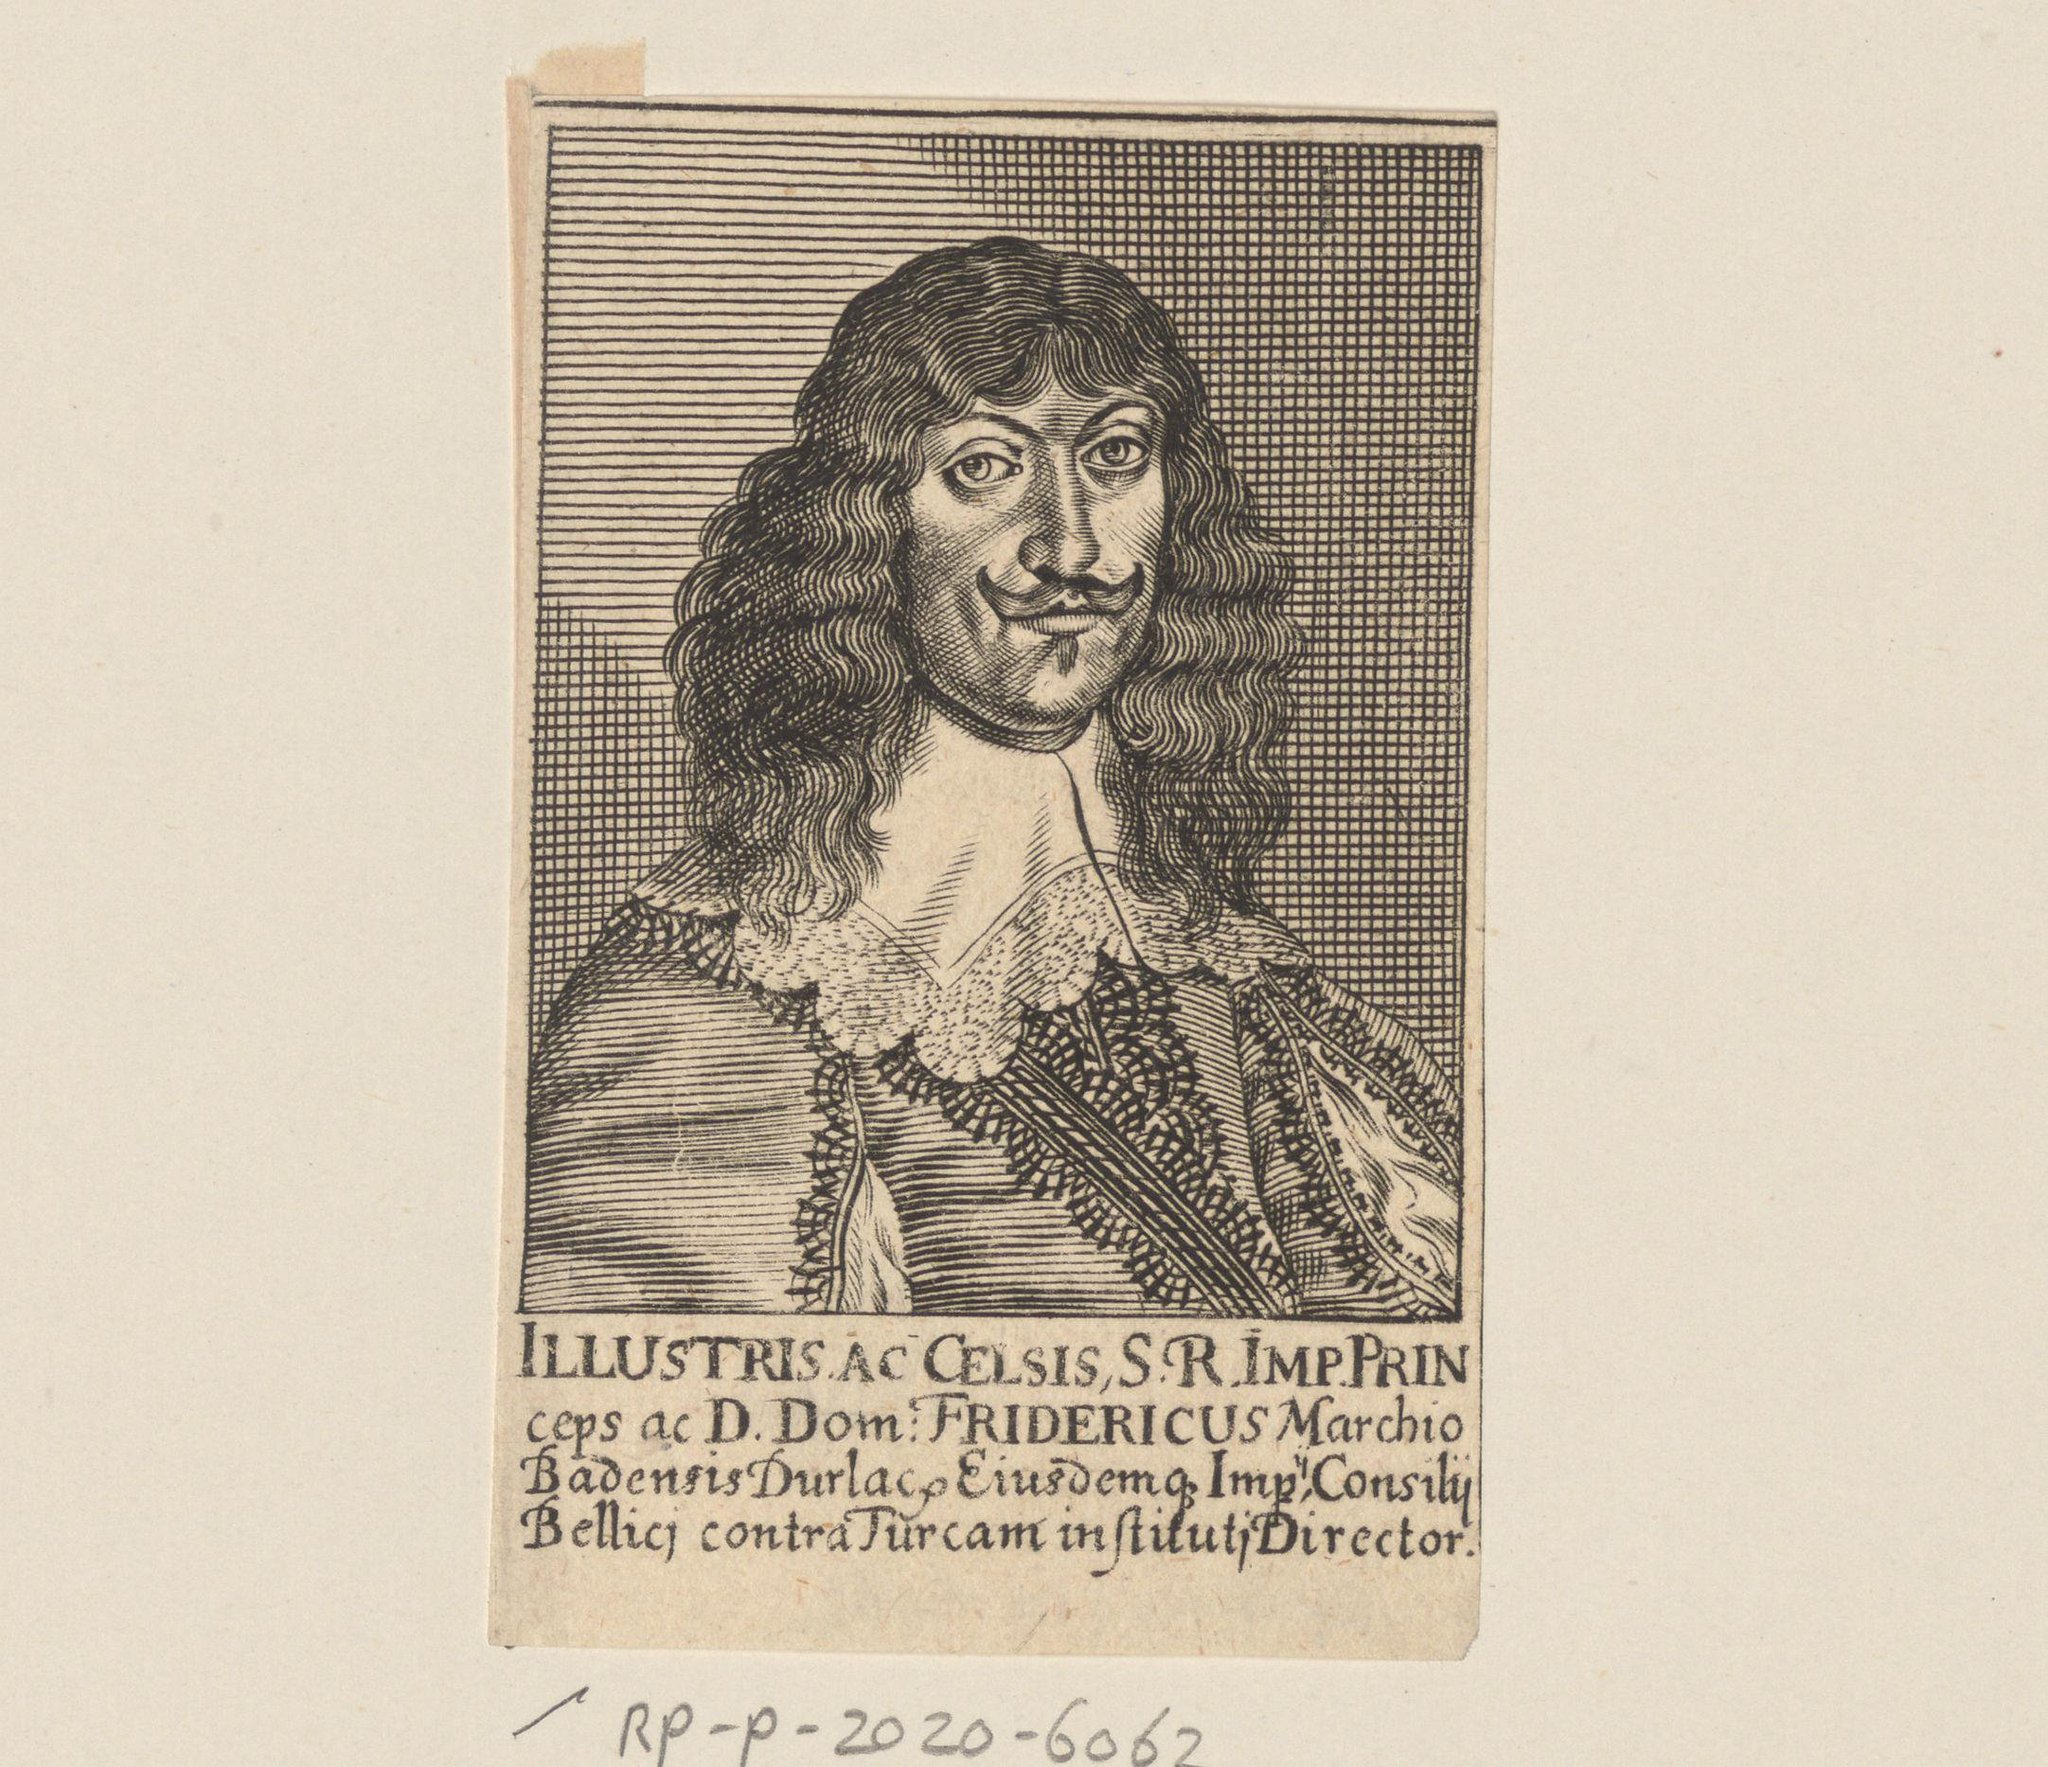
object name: book illustration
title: Portret van Frederik V van Baden-Durlach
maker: Anonymous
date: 1650-1750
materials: paper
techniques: engraving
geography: germany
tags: historical persons